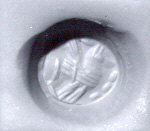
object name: stamp seal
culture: sasanian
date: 201-700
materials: stone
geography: iran